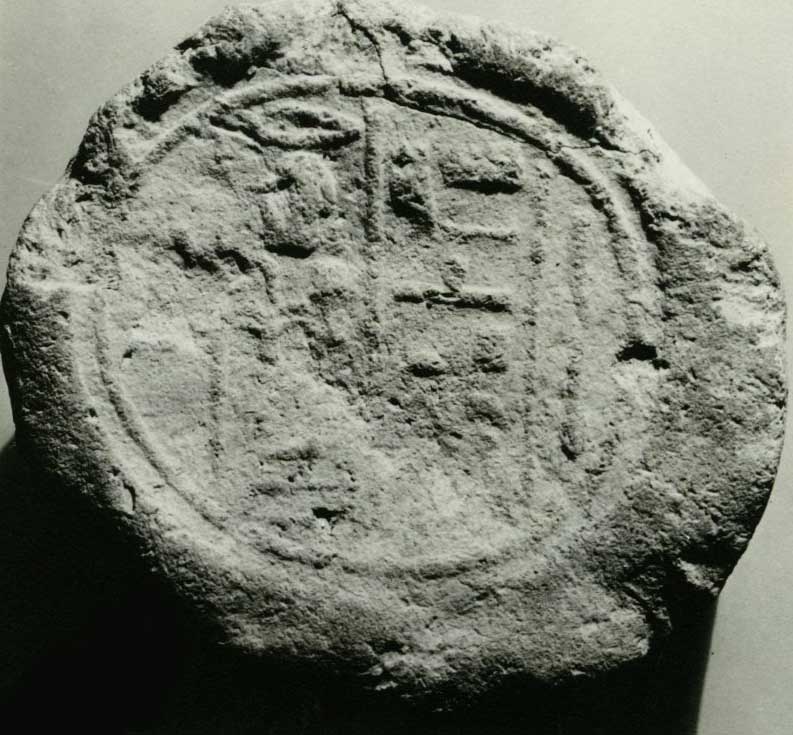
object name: cone, suemniut, royal cup bearer, circular impression,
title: Funerary Cone of the Cup-Bearer of the King Amenhotep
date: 1550-1295 BCE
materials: pottery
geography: egypt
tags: hieroglyphs